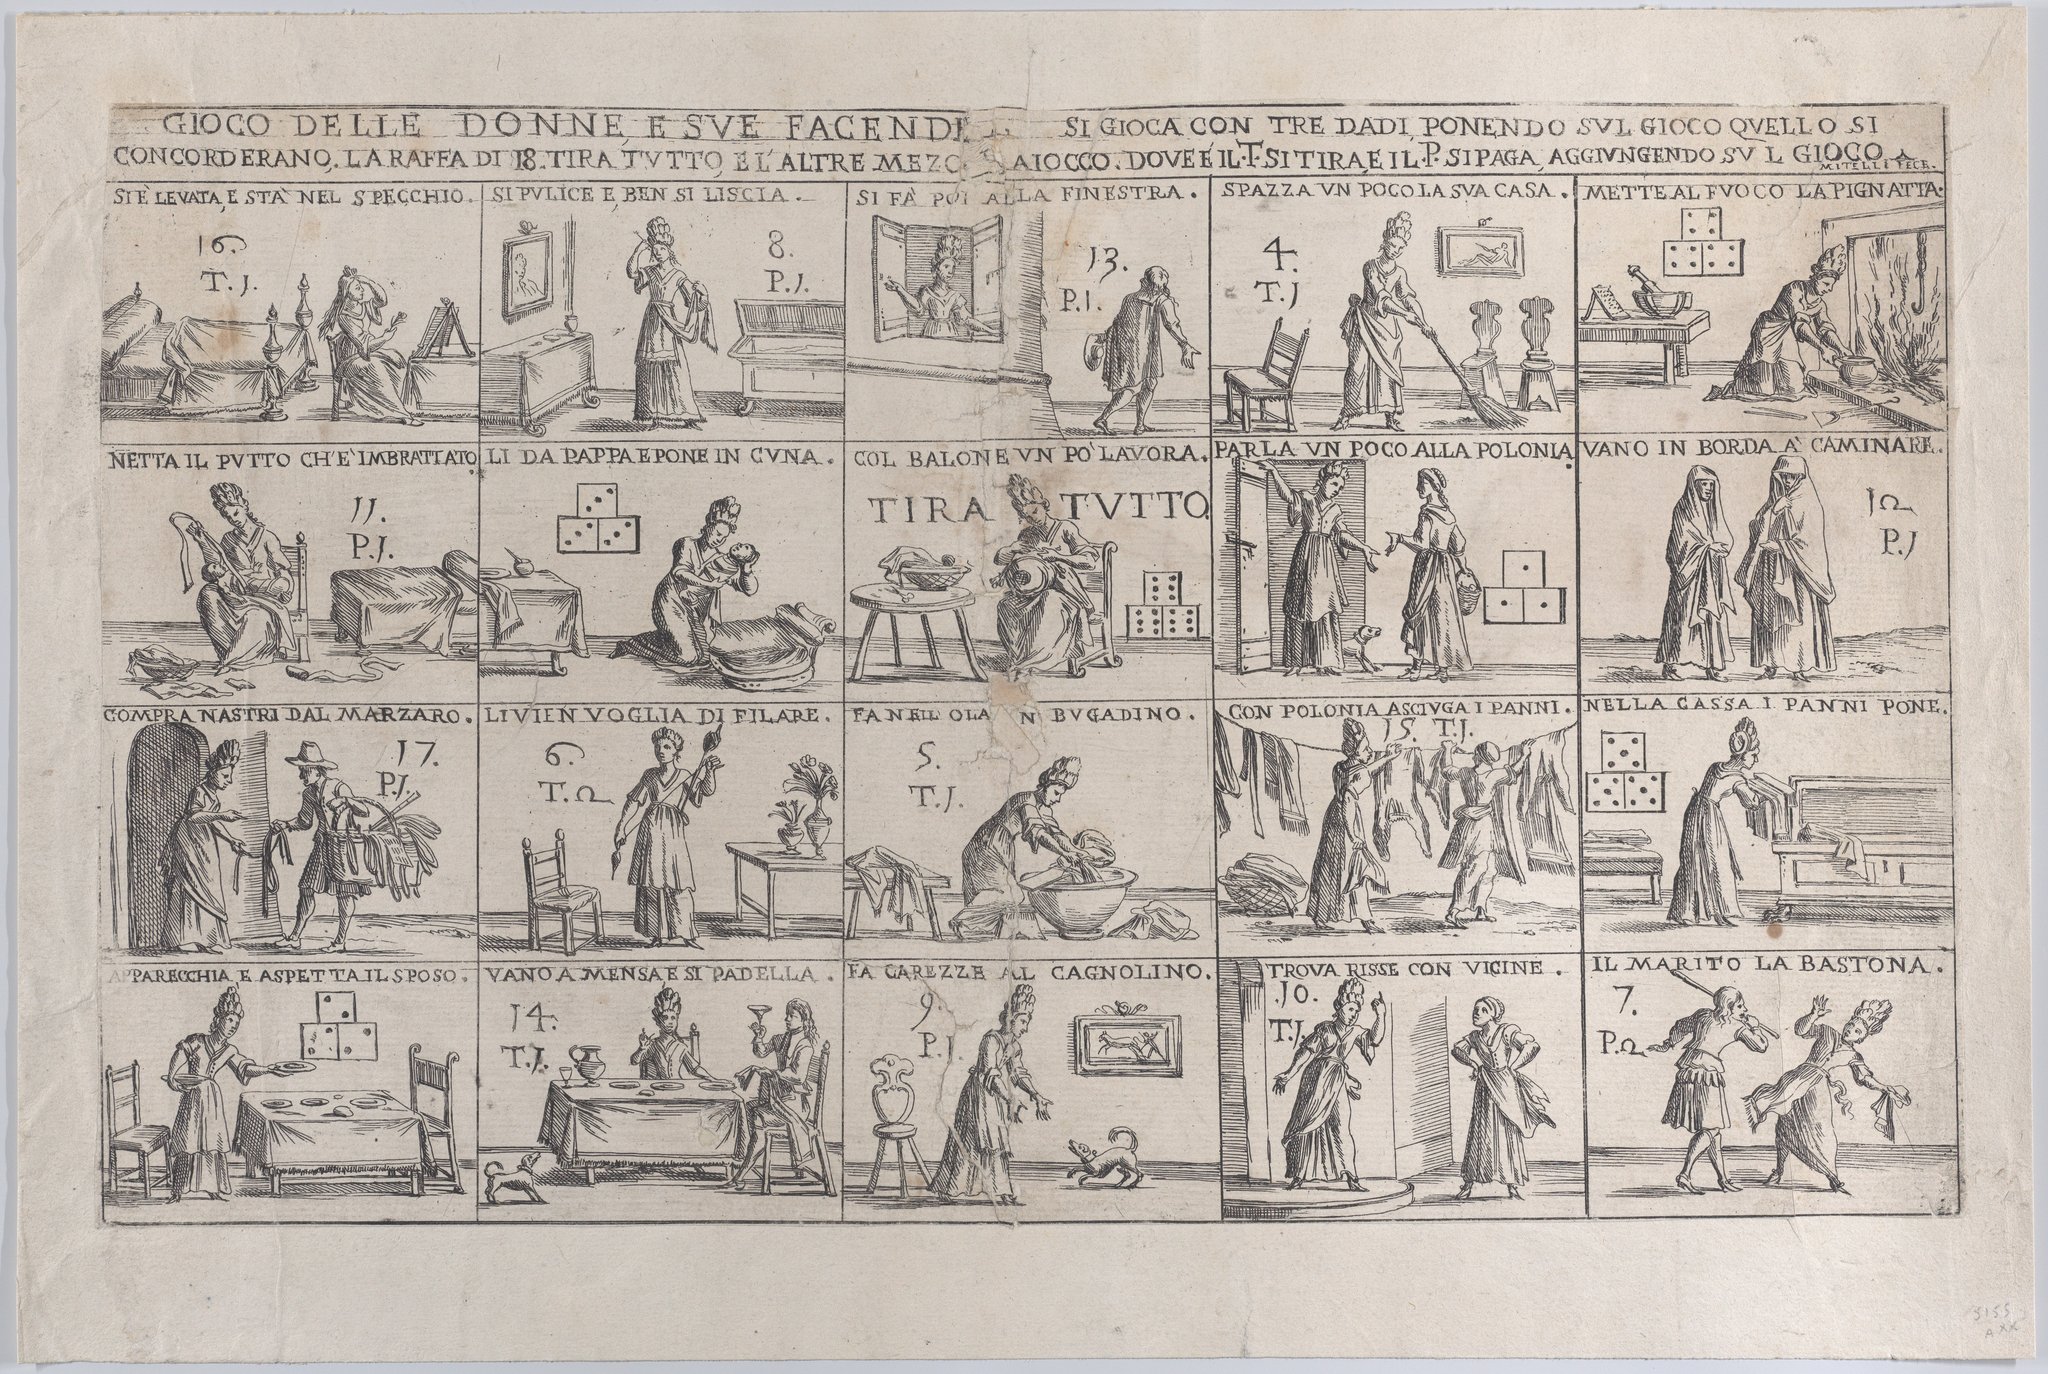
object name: print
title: Gioco Delle Donne, E Sue Facende (Game of Wives, And Their Chores)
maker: giuseppe maria mitelli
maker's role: artist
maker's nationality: italian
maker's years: 1634-1718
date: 1654-1718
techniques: etching